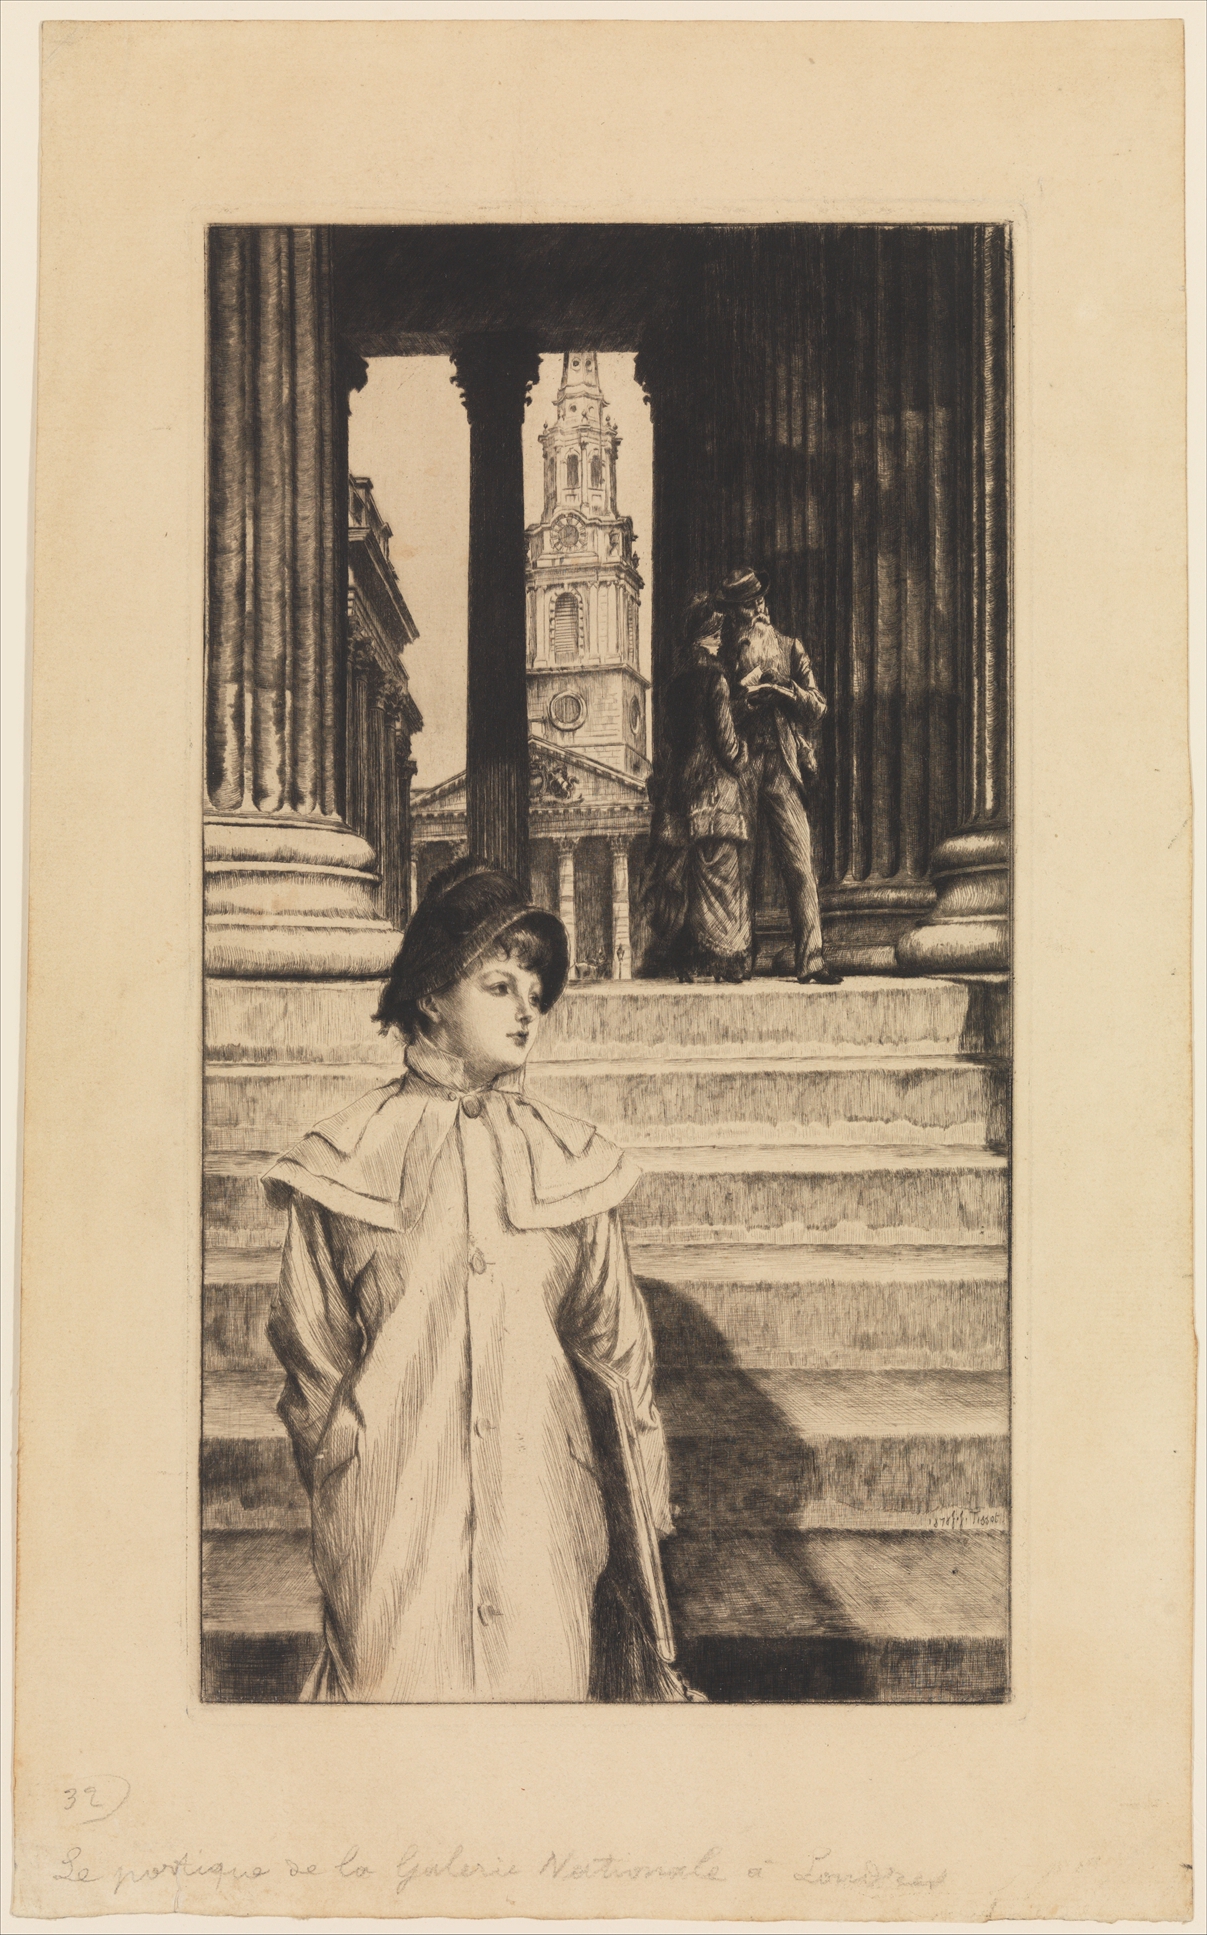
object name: print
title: The Portico of the National Gallery, London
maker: james tissot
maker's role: artist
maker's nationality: french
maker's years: 1836-1902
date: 1878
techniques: drypoint, etching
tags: men,women,london